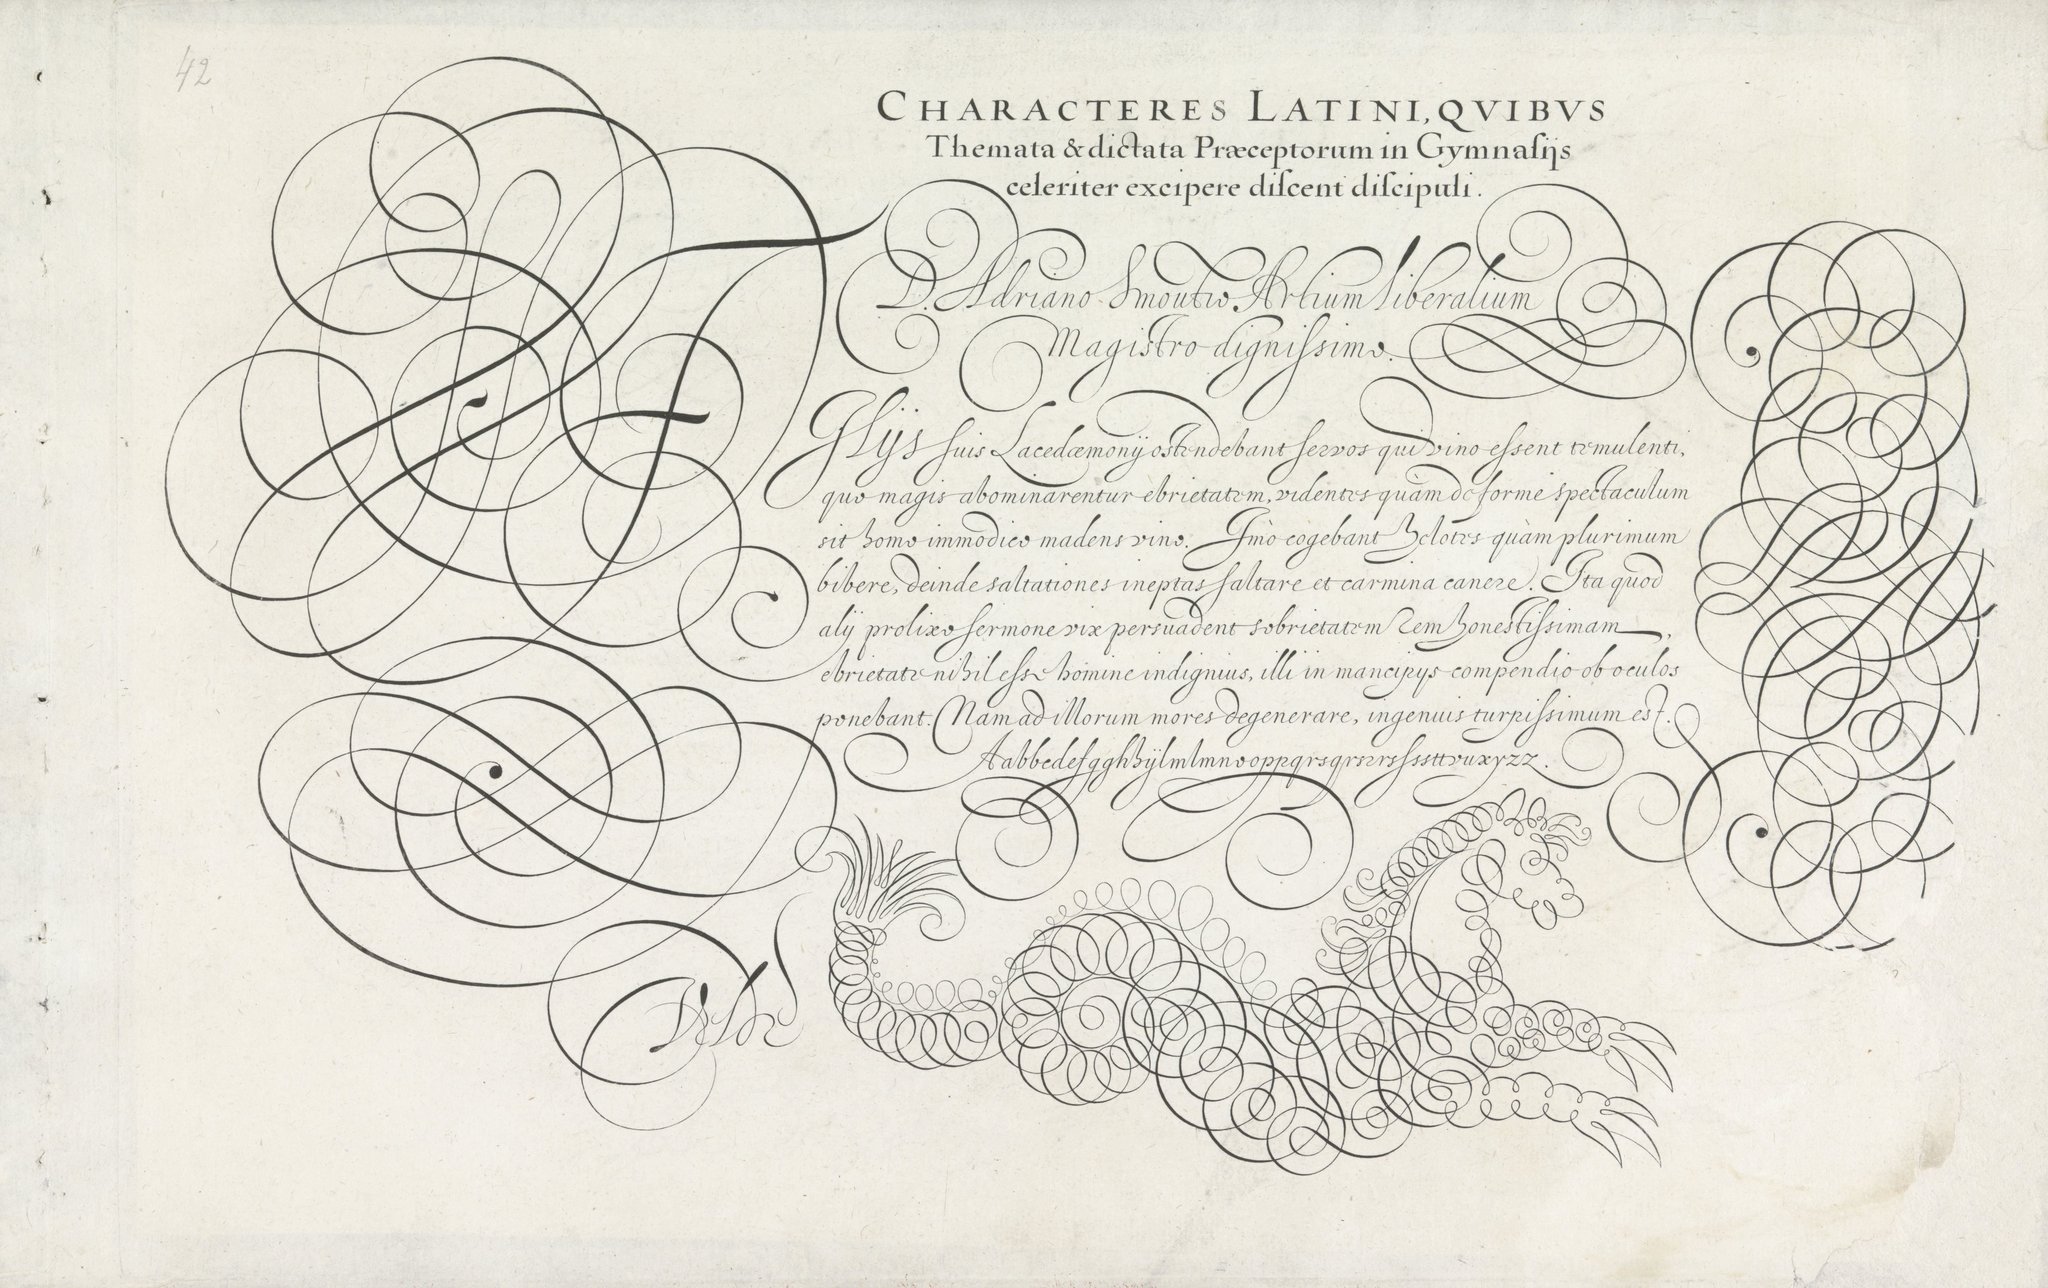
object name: print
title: Schrijfvoorbeeld: Characteres Latini (...)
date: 1605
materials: paper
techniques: engraving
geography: haarlem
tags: calligraphy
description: Schrijfvoorbeeld met de aanhef: Characteres Latini ... en een dedicatie in twee regels: D. Adriano Smoutio artium liberalium magistro dignissimo. Daaronder een initiaal F en acht regels tekst in het Latijn: Filijs suis Lacedaemony ... De tekst eindigt met een onderkastalfabet in dezelfde hand. Rechts en links krulwerk. Onderaan een (zee)paard in krulwerk. De prent maakt deel uit van een album.